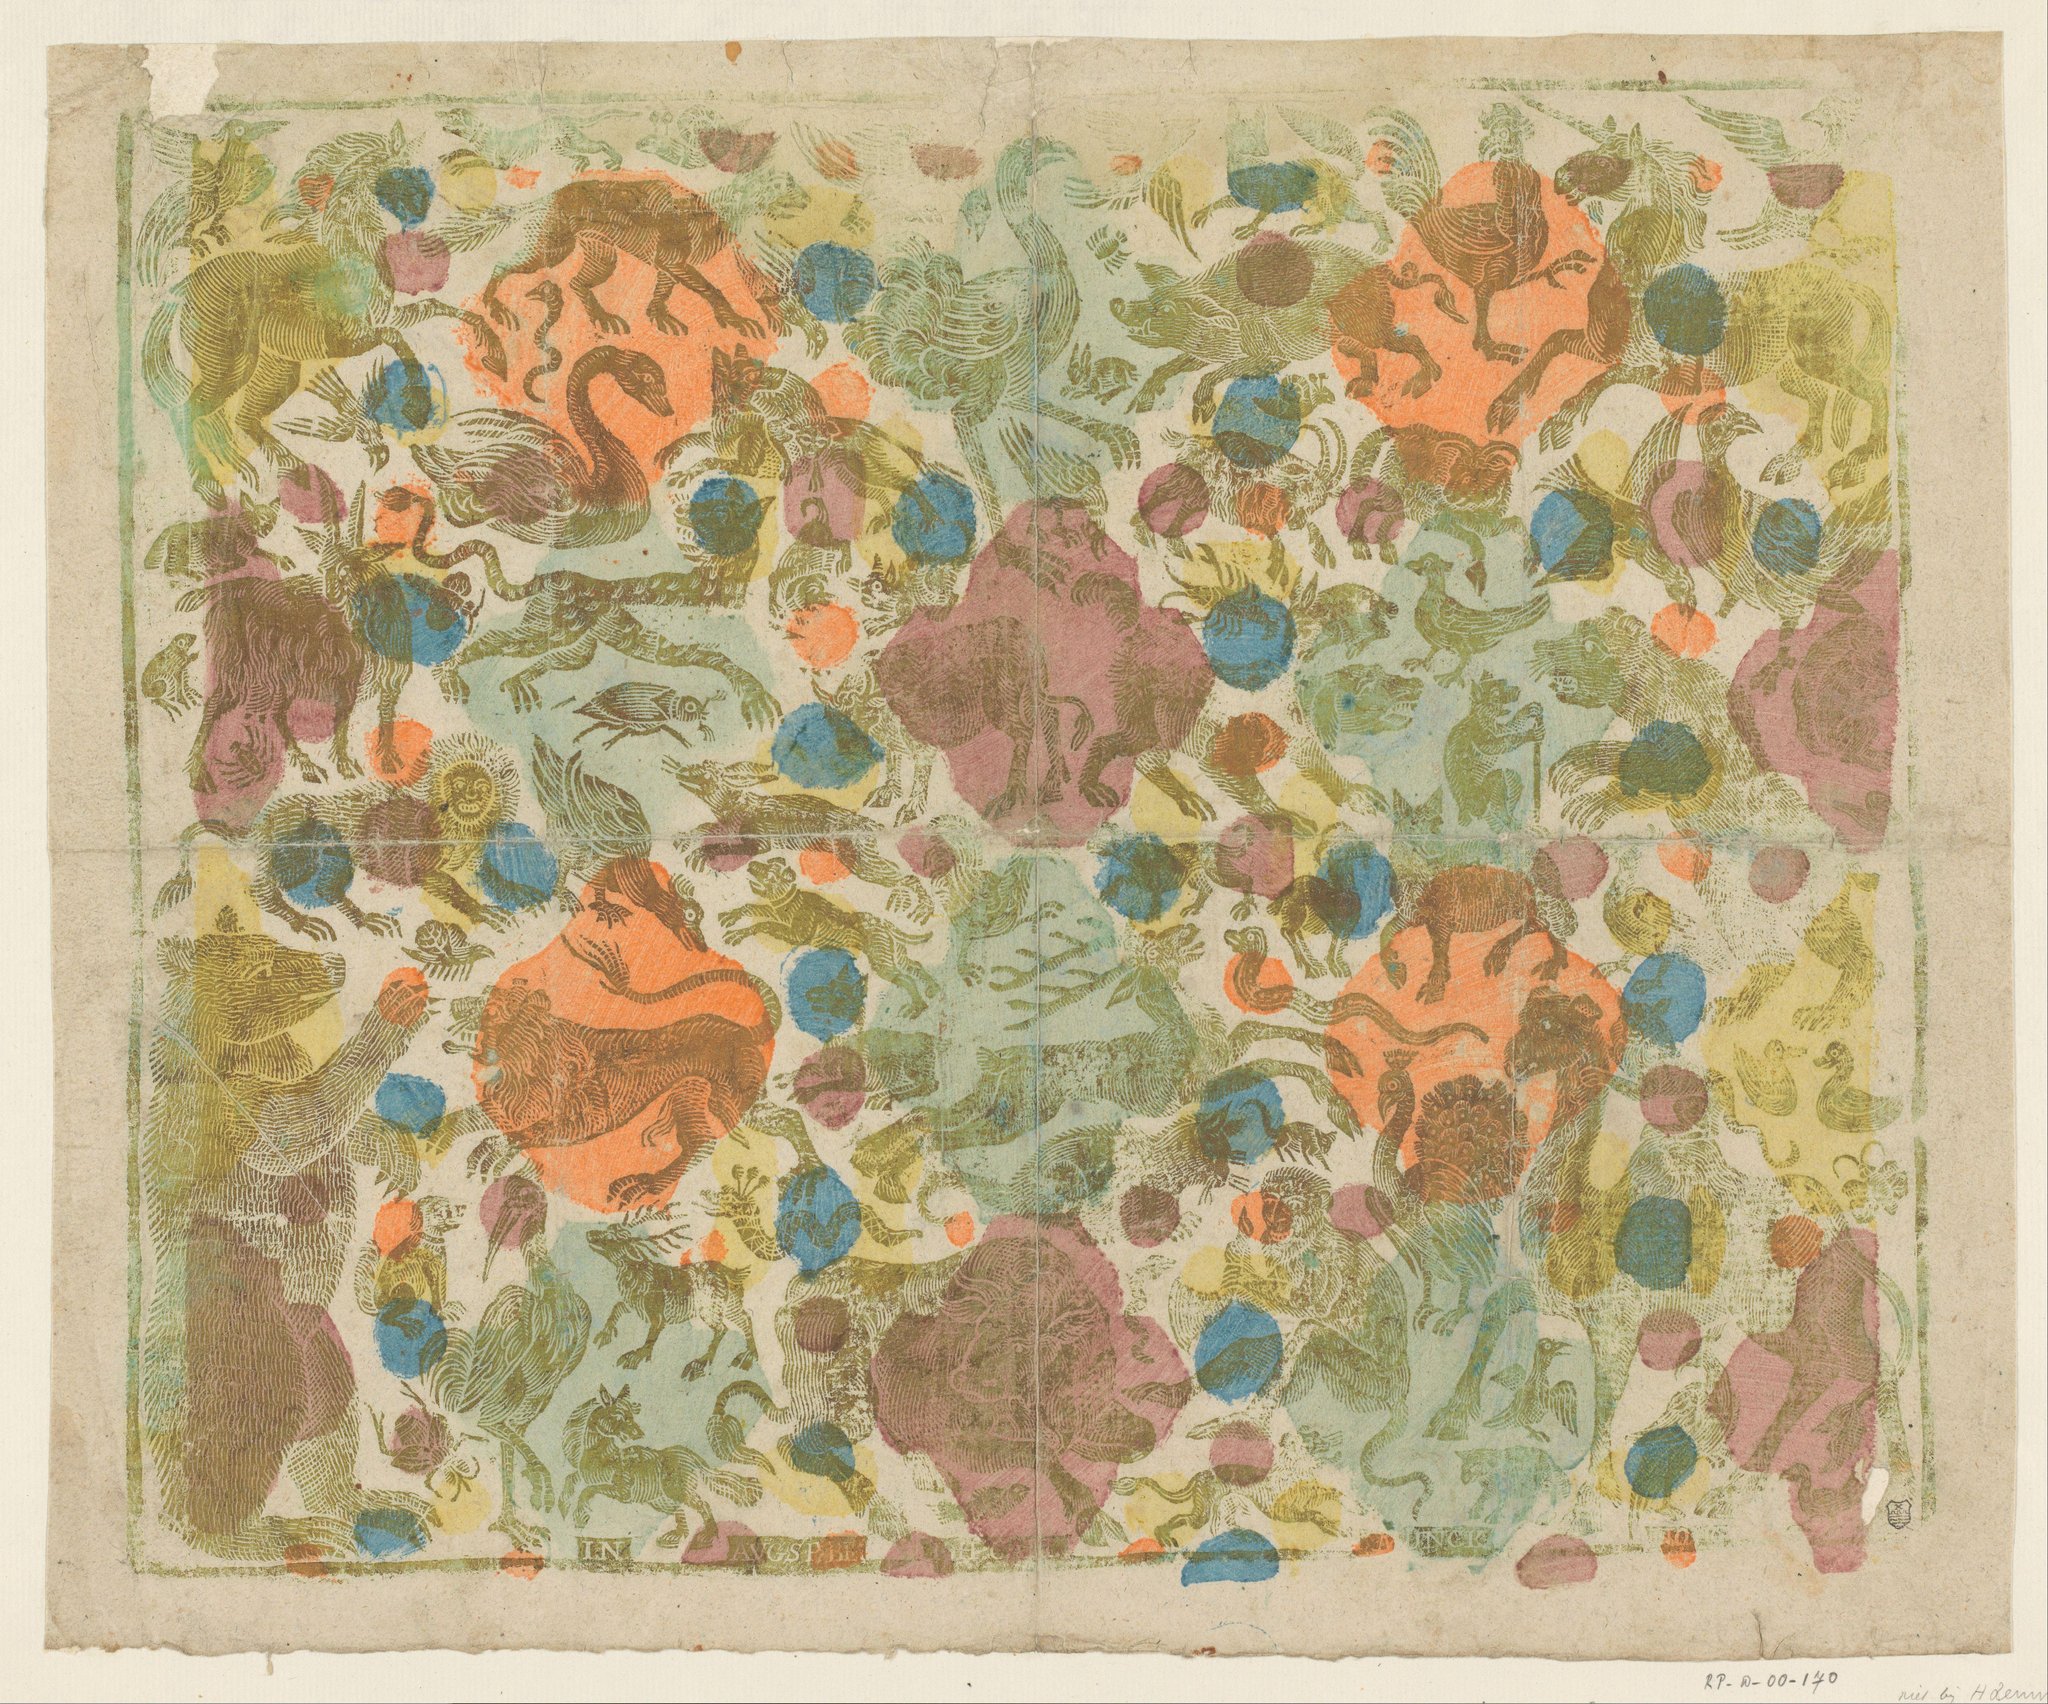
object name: brocade paper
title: Blad met dieren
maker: johann carl munck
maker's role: ontwerper sierpapier, papiermaker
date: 1750-1794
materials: gold leaf, paint, paper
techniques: relief print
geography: augsburg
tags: unicorn, animals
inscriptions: collector's mark: Lugt 2760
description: Blad met dieren; linksboven paard, rechtsboven eenhoorn, linksonder beer, rechtsonder dromedaris. Onderaan genummerd: 16.